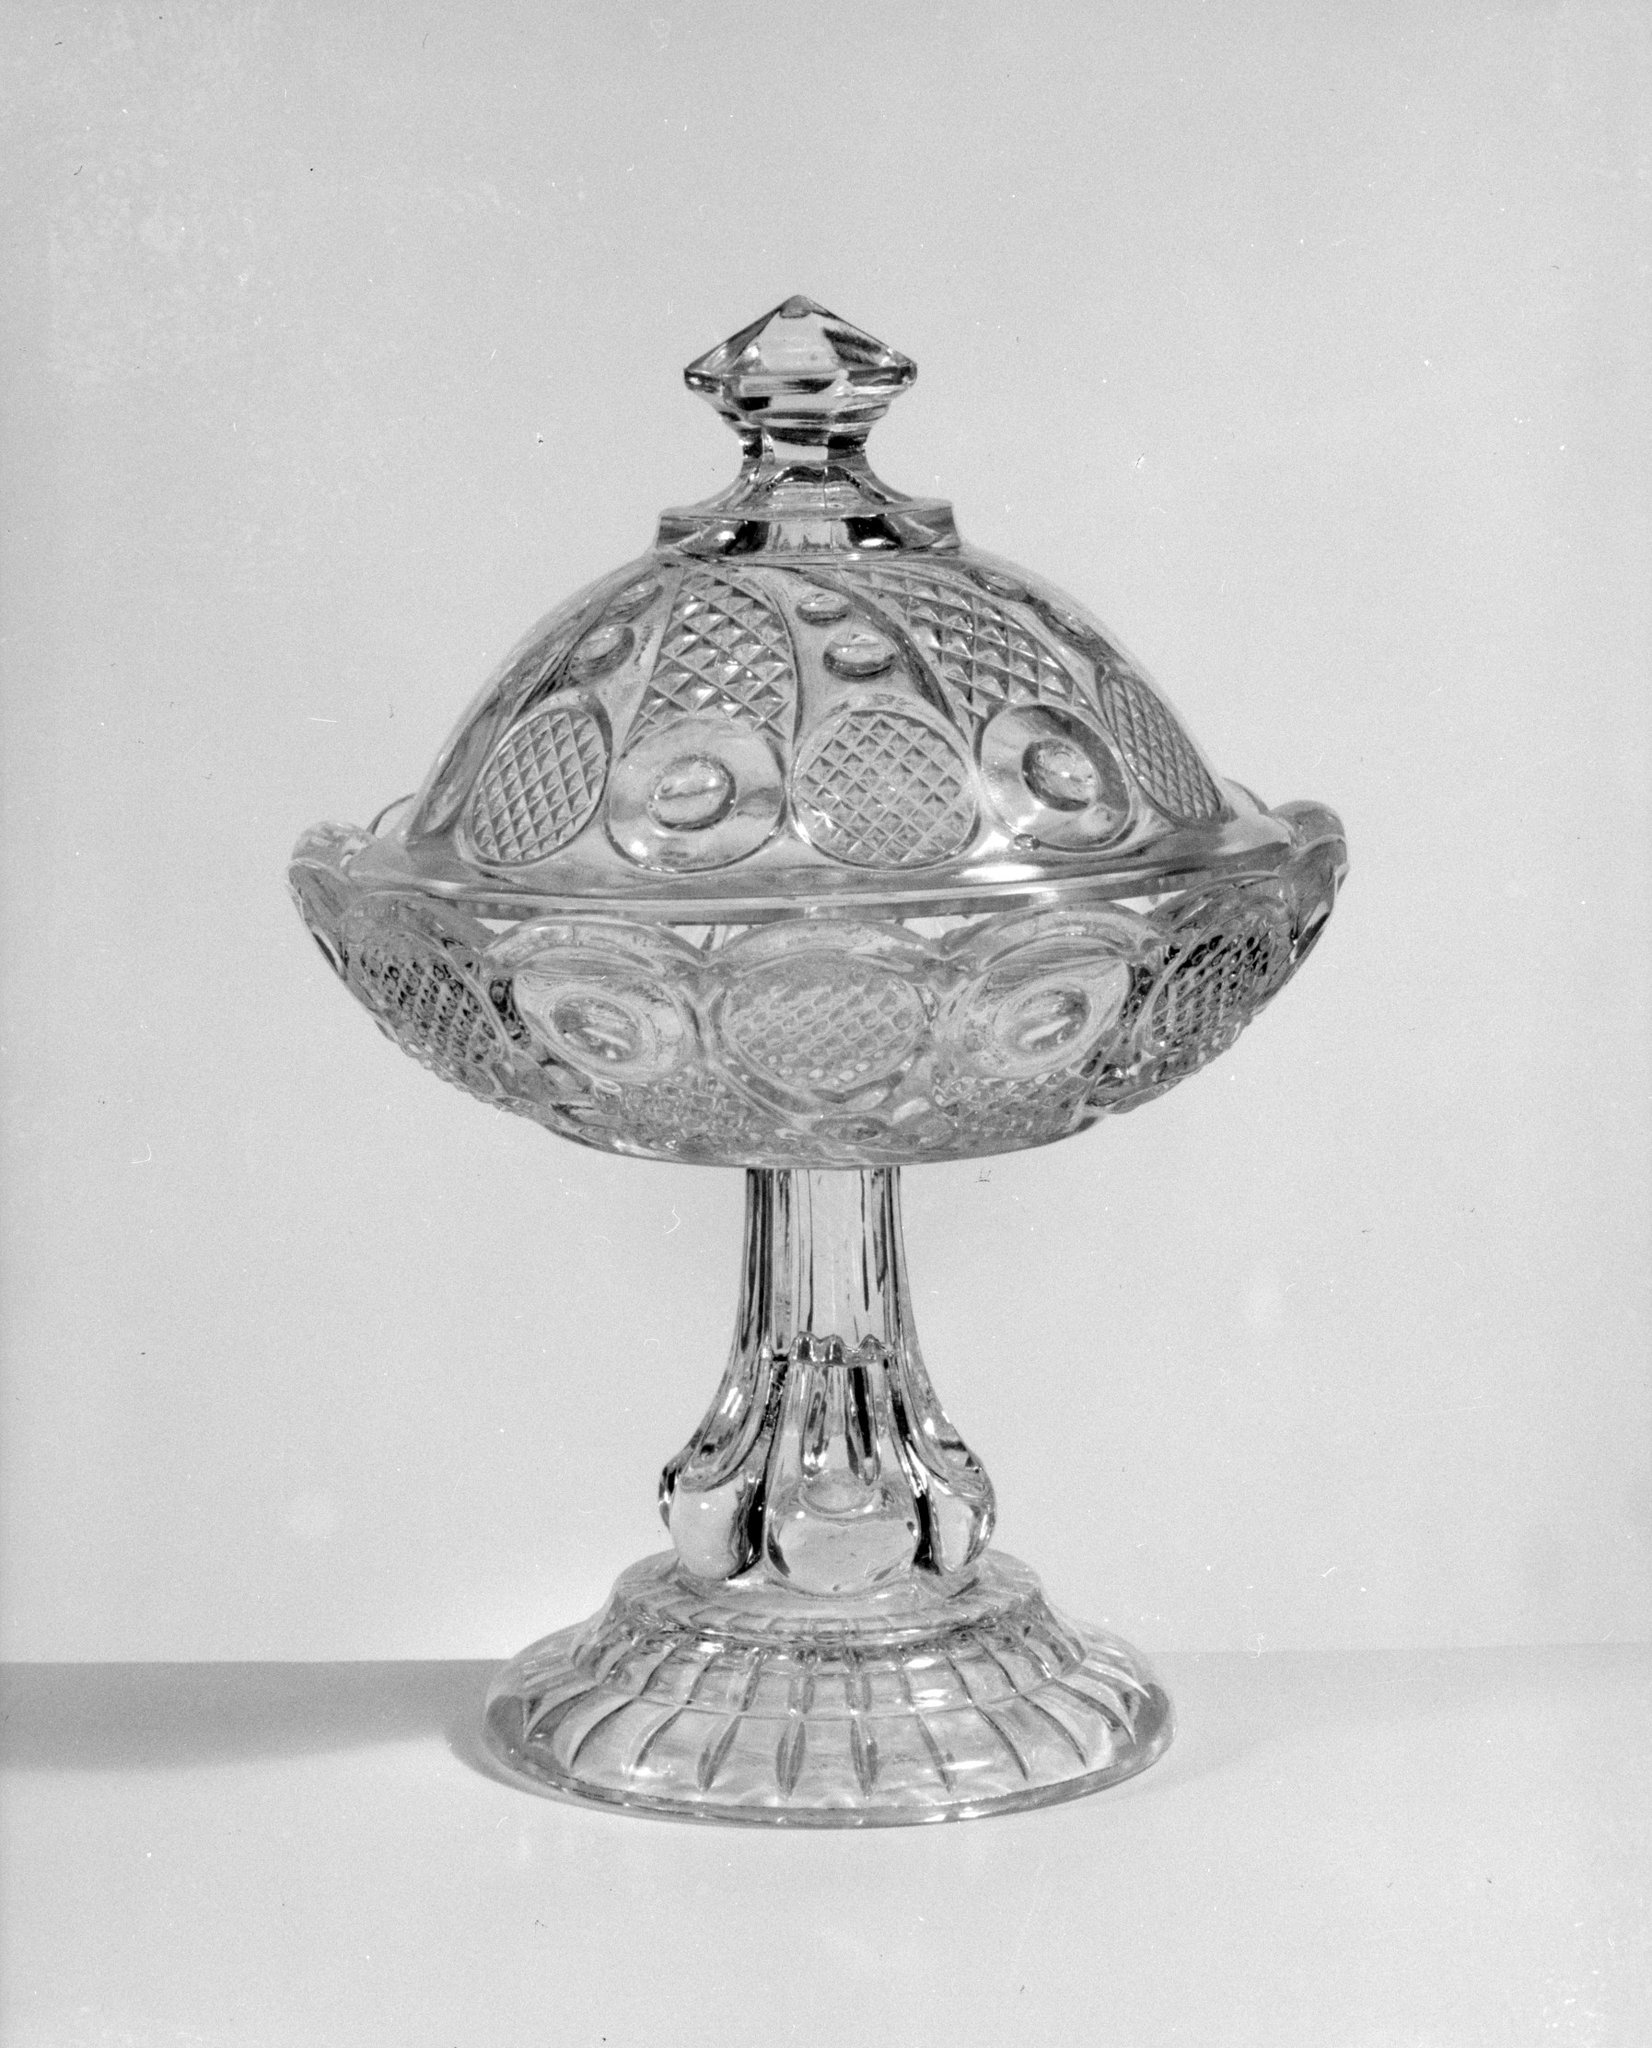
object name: compote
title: Covered Compote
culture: american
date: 1850-1870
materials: glass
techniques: pressed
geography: united states